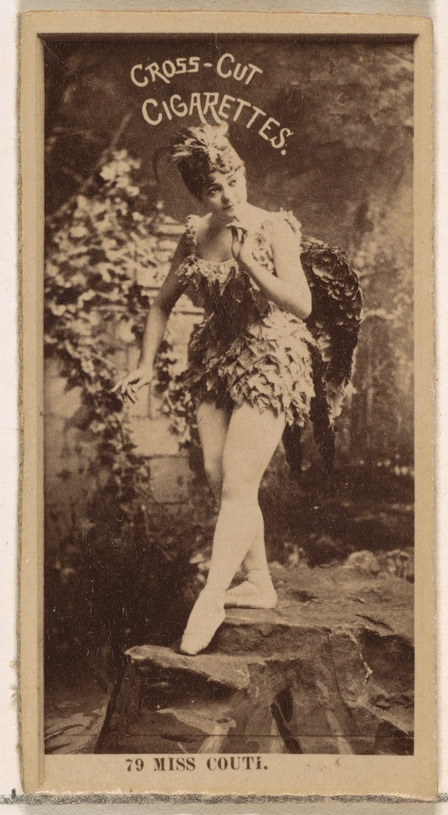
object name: print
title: Card Number 79, Miss Couti, from the Actors and Actresses series (N145-2) issued by Duke Sons & Co. to promote Cross Cut Cigarettes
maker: w. duke, sons & co.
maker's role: publisher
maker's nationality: american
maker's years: 1870-1920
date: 1880-1889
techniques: albumen silver print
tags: portraits,women,actresses